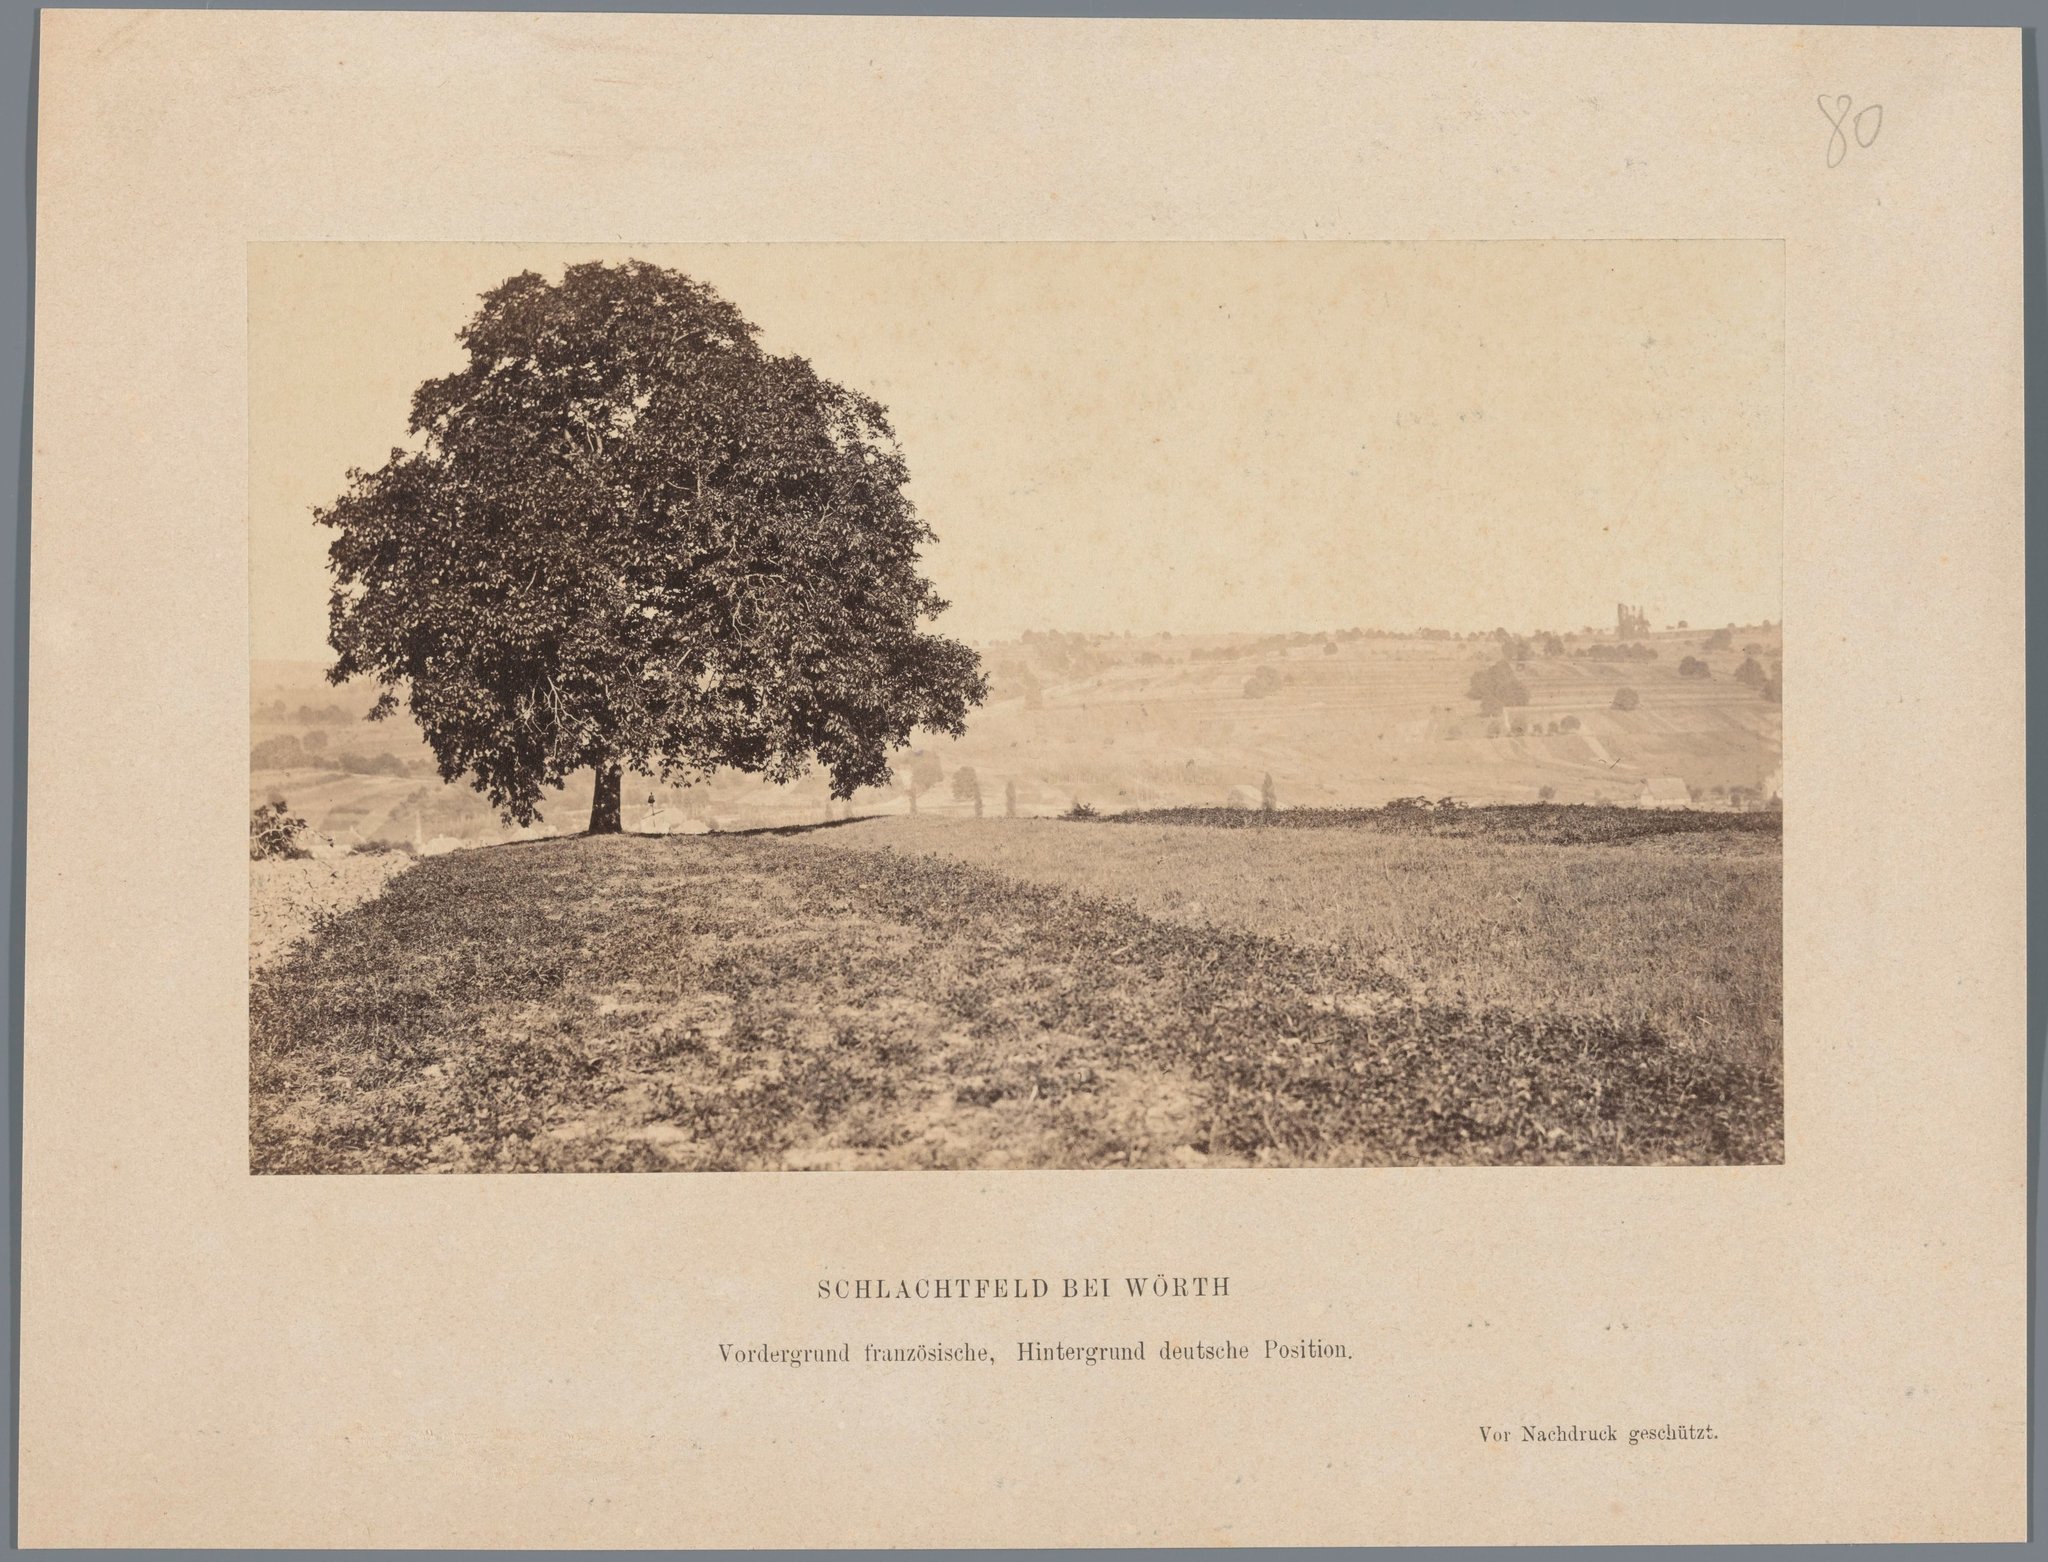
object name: photograph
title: Terrein waar op 6 augustus 1870 de Slag bij Wörth plaatsvond tijdens de Frans-Duitse oorlog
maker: Anonymous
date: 1870-1875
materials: cardboard, paper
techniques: albumen print, letterpress printing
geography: woerth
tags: low hill country, trees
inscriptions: number: ‘80’, inscription: ‘Vördergrund französische, Hintergrund deutsche Position./ Vor Nachdruck geschützt.’